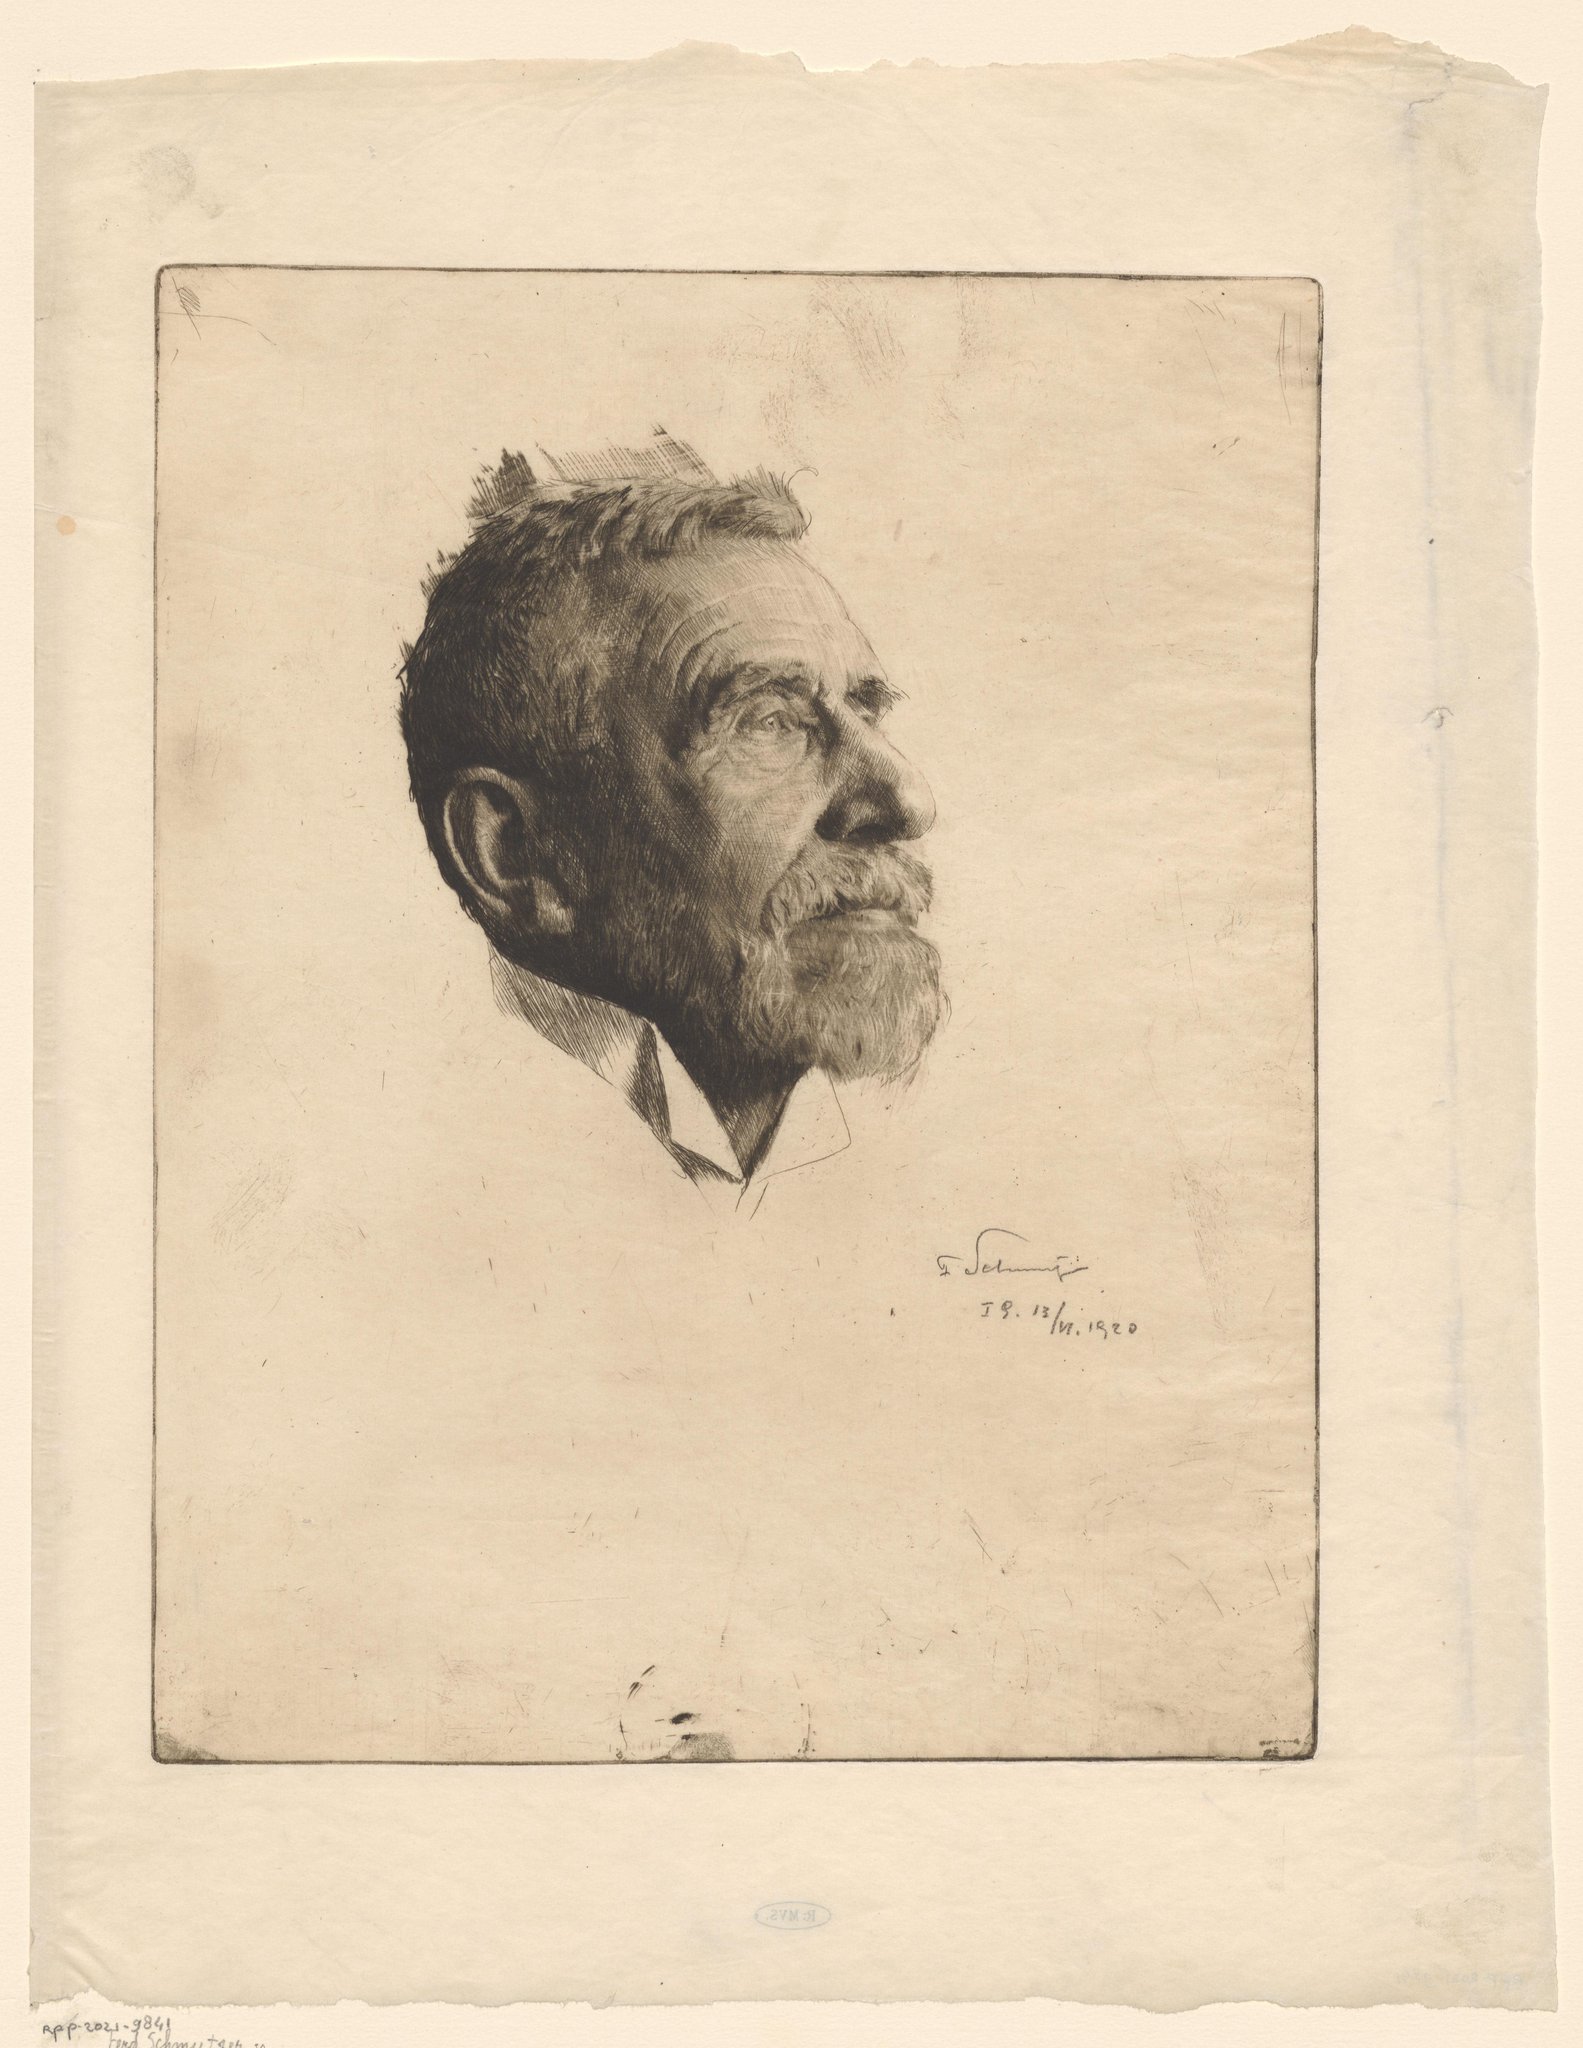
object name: print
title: Portret van Friedrich Ohmann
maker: ferdinand schmutzer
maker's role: painter, print maker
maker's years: 1870-1928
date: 1920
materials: paper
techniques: etching, intaglio, roulette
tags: adult man, historical persons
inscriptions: collector's mark: Lugt 2228